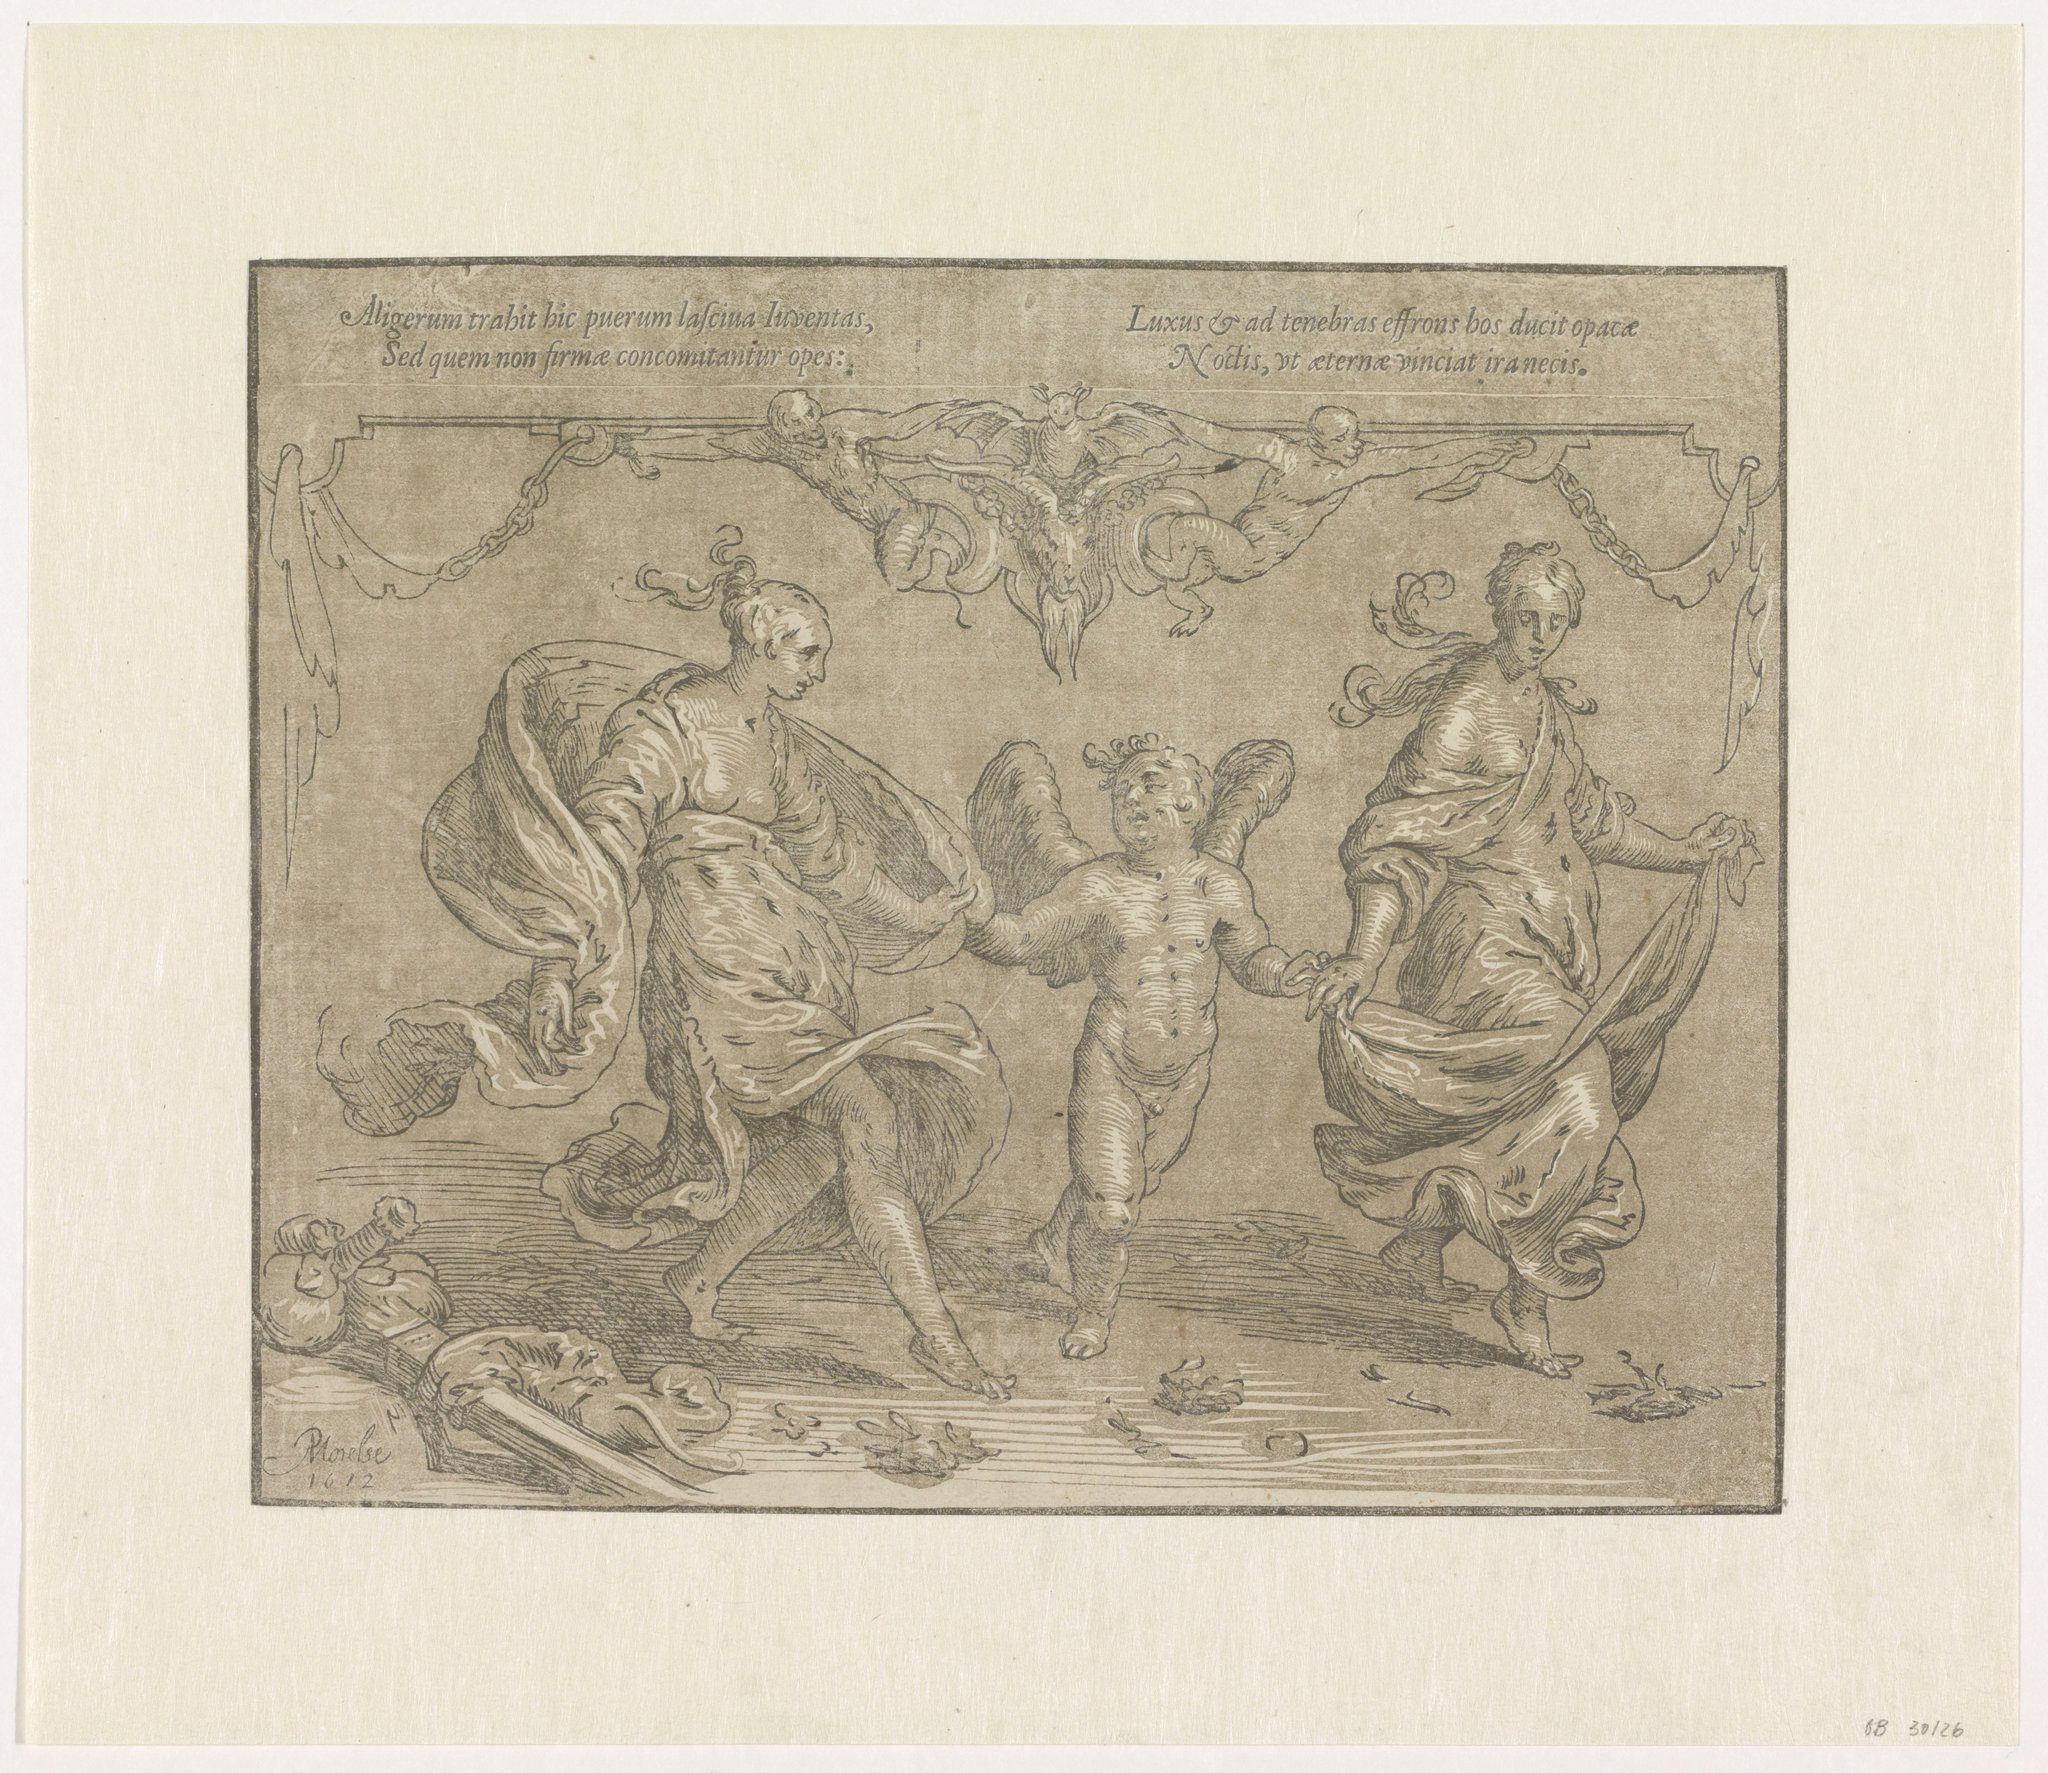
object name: print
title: Cupido danst met twee allegorische vrouwfiguren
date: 1612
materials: paper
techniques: woodcut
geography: netherlands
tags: dancing, (story of) cupid, amor (eros)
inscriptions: collector's mark: Lugt 240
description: Cupido danst met twee allegorische vrouwfiguren. In de bovenmarge twee kolommen met elk twee regels Latijnse tekst.